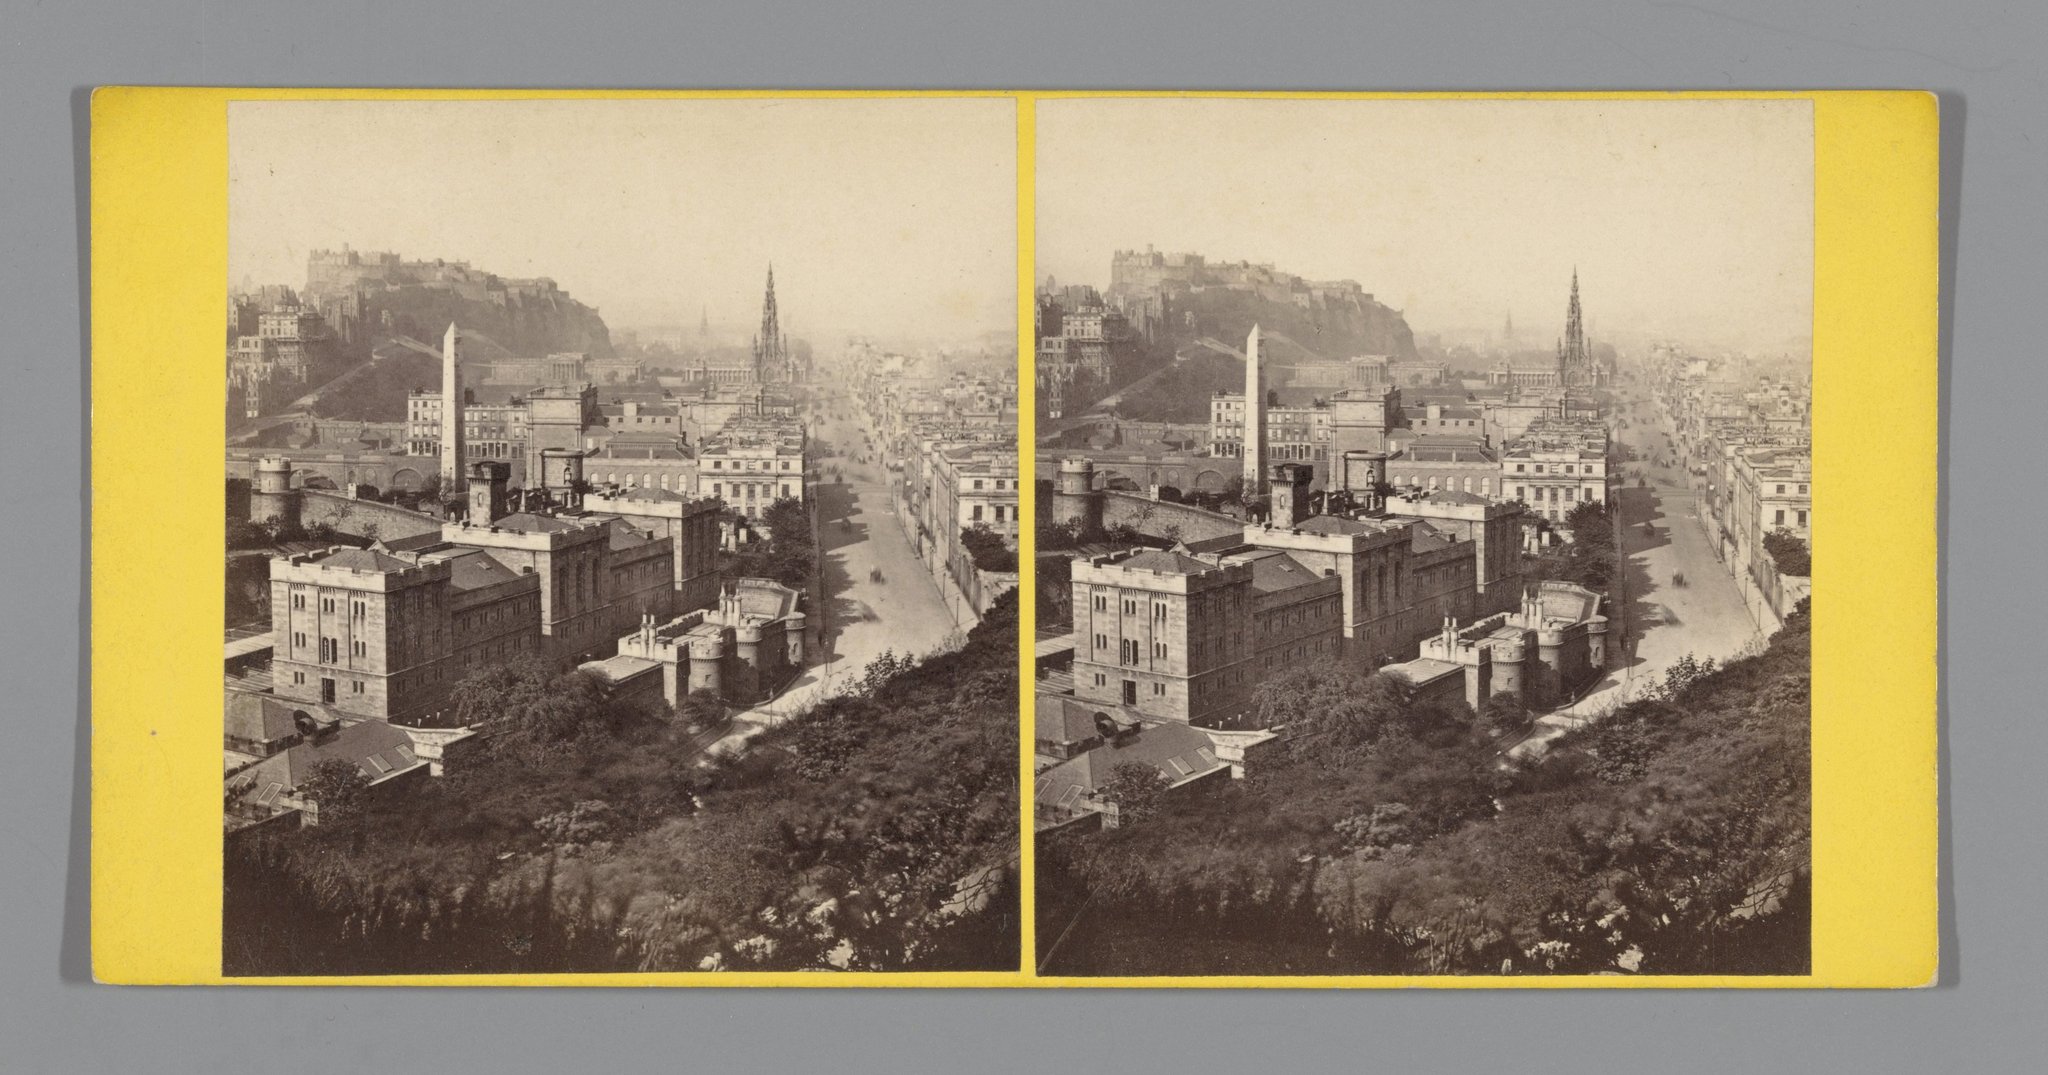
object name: stereograph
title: Gezicht op Edinburgh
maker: george washington wilson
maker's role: publisher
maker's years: 1823-1893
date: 1850-1880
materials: cardboard, photographic support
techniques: albumen print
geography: edinburgh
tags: city-view in general; 'veduta'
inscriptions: name: ‘Registered G. W. Wilson, Photographer, Aberdeen’, number: ‘No. 107.’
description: Het object RP-F-F04806 is vermoedelijk tijdens dezelfde fotografeersessie gemaakt.